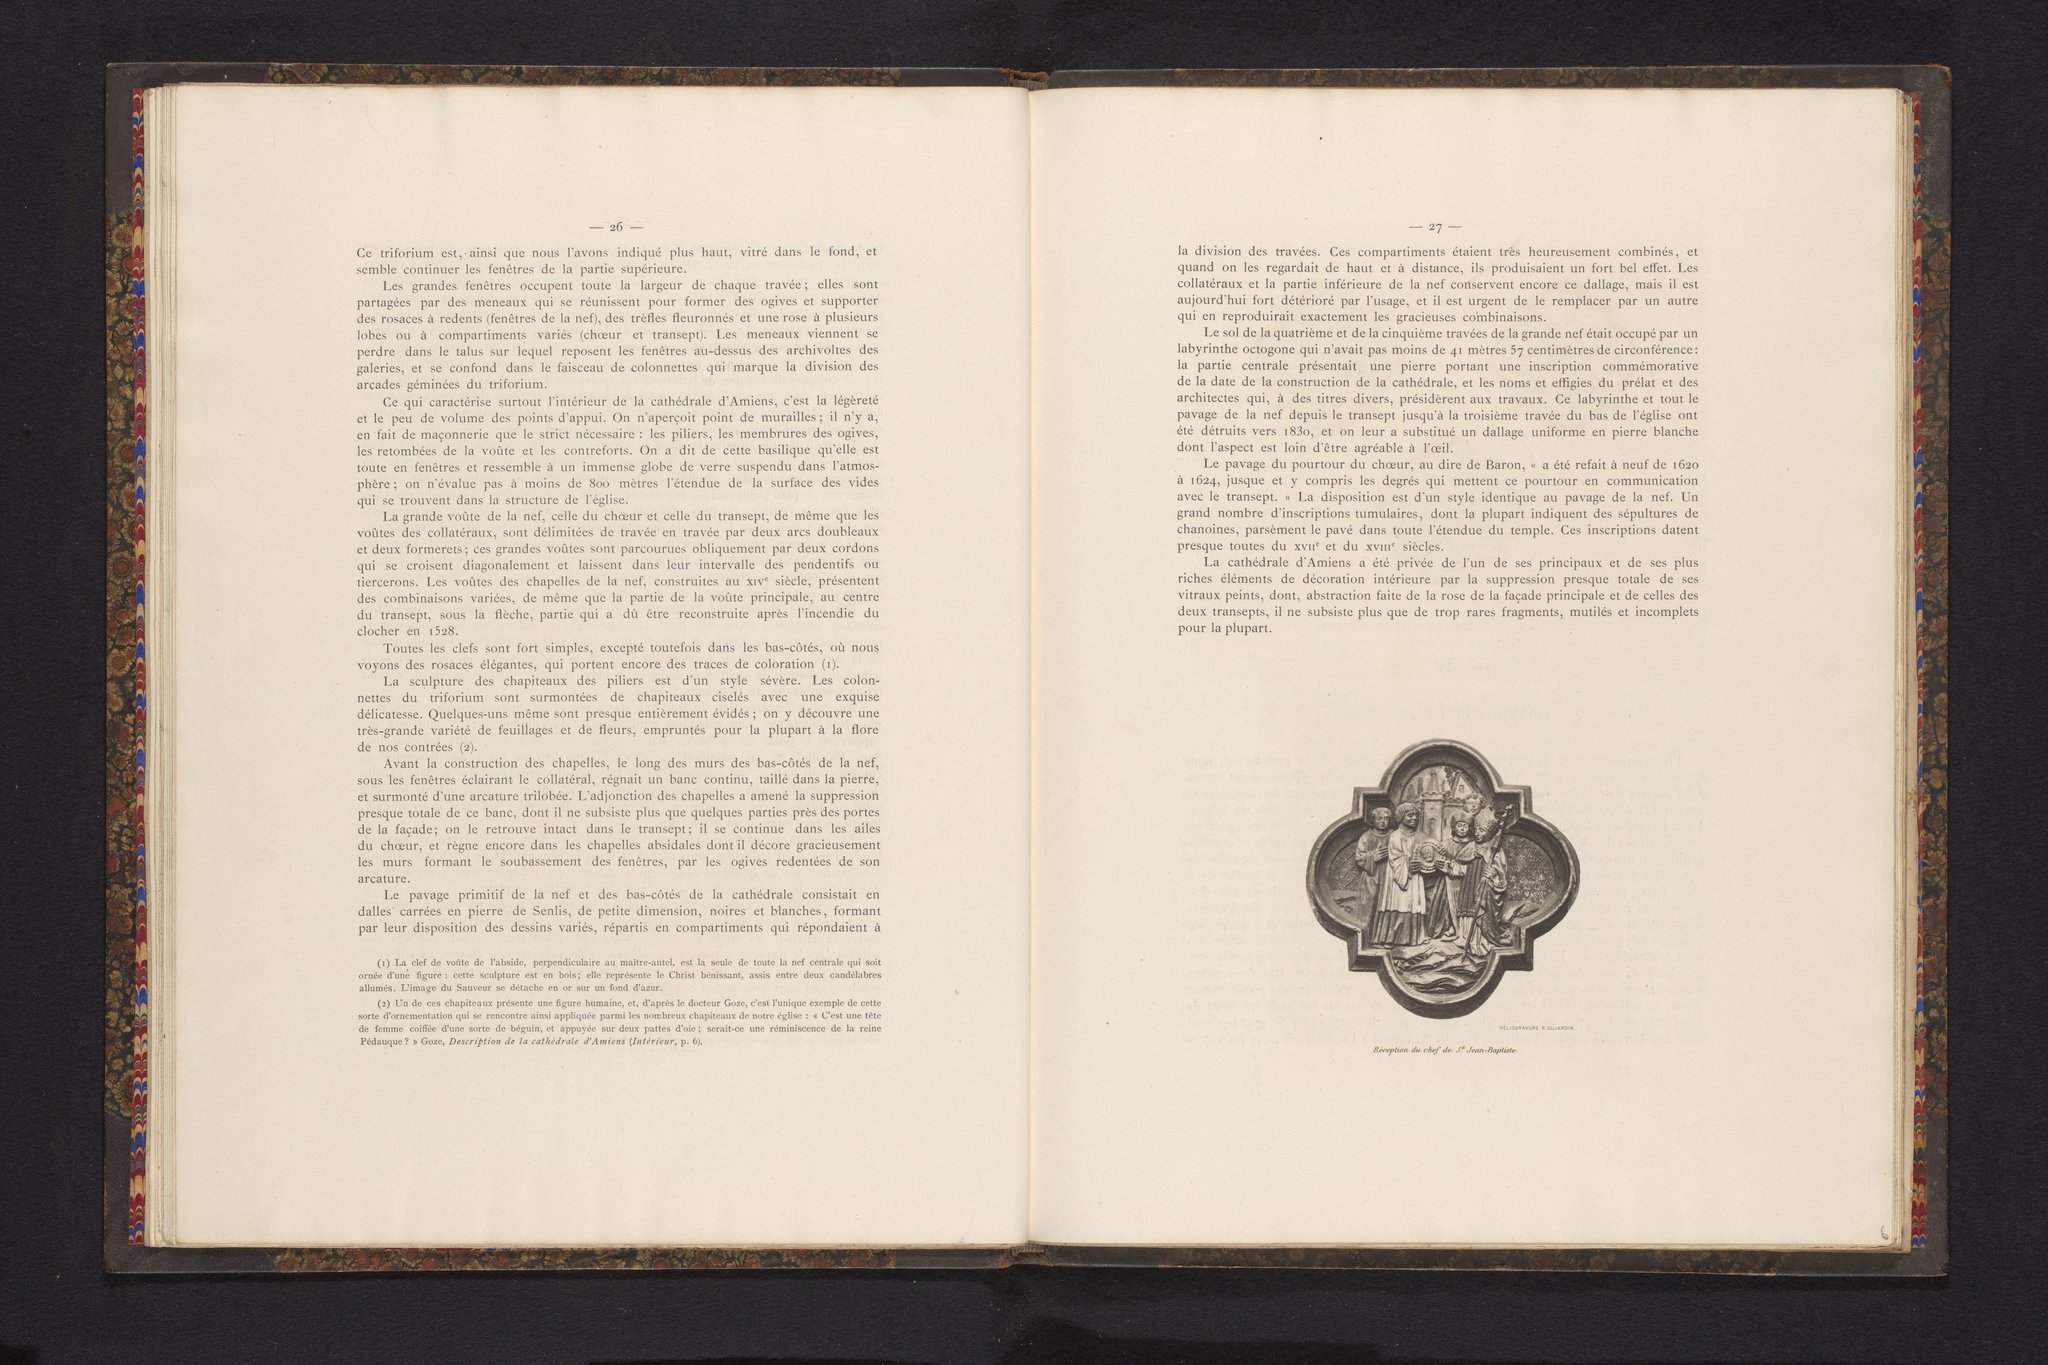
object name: page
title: Reliëf met Johannes de Doper in de Notre-Dame van Amiens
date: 1888-1893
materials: paper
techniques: photograph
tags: series of scenes from the life of john the baptist, sculpture (+ relief ~ sculpture), notre-dame d'amiens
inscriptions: inscription: ‘Réception du chef de St. Jean-Baptiste’